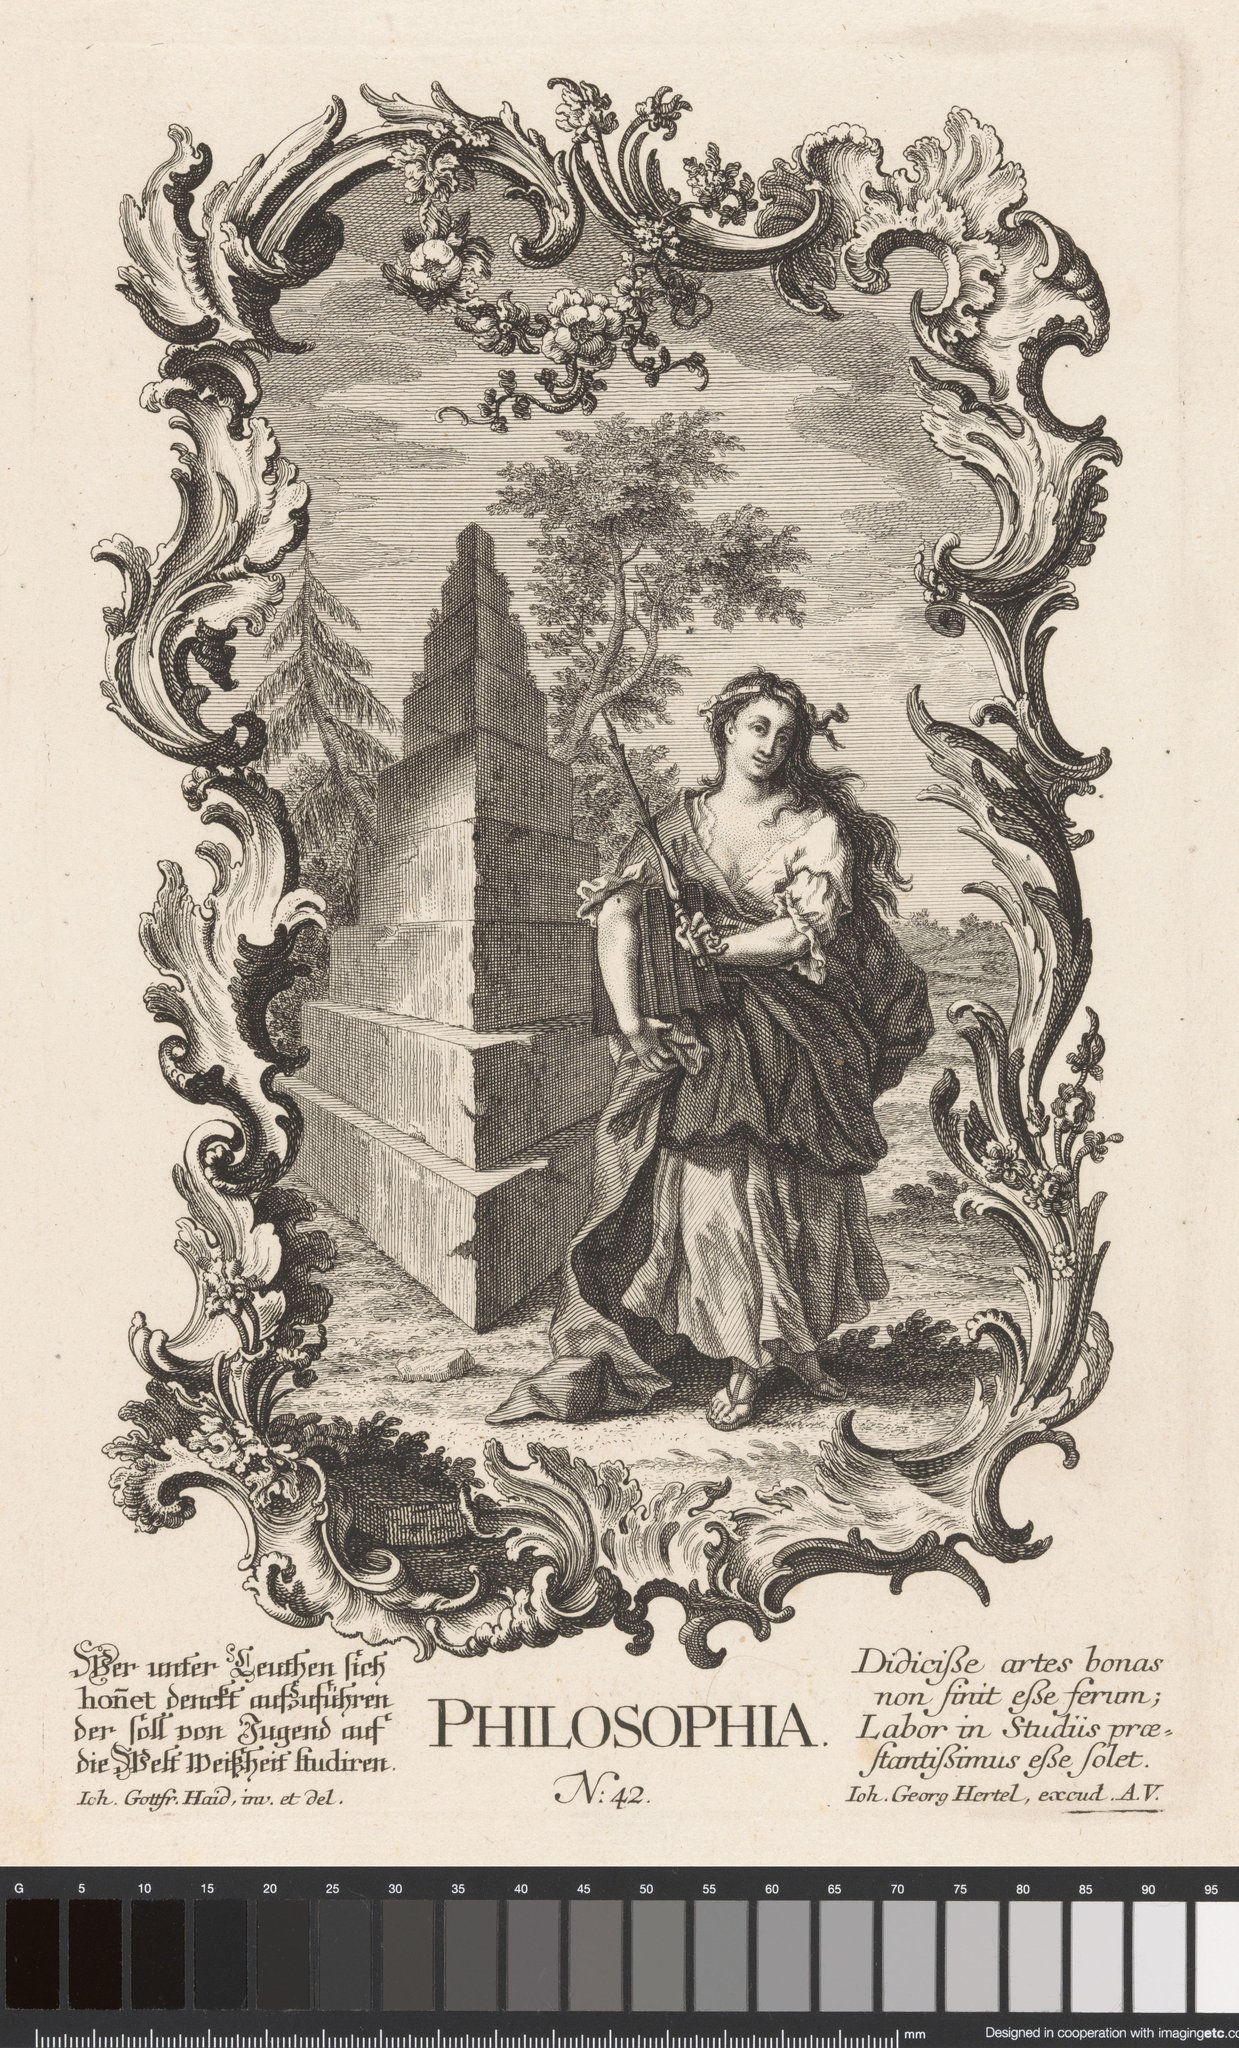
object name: ornament print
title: Philosophia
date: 1745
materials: paper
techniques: etching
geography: augsburg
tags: 'philosophia'; 'filosofia' (ripa), standing figure - aa - female human figure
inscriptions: collector's mark: Lugt 2228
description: Allegorie van de filosofie, omgeven door een rocaille omlijsting. Een vrouw met boeken en een scepter staat in een landschap naast een trappiramide. In de ondermarge tweemaal een vierregelige Duitse en Latijnse tekst. Uitgeversnummer 42.